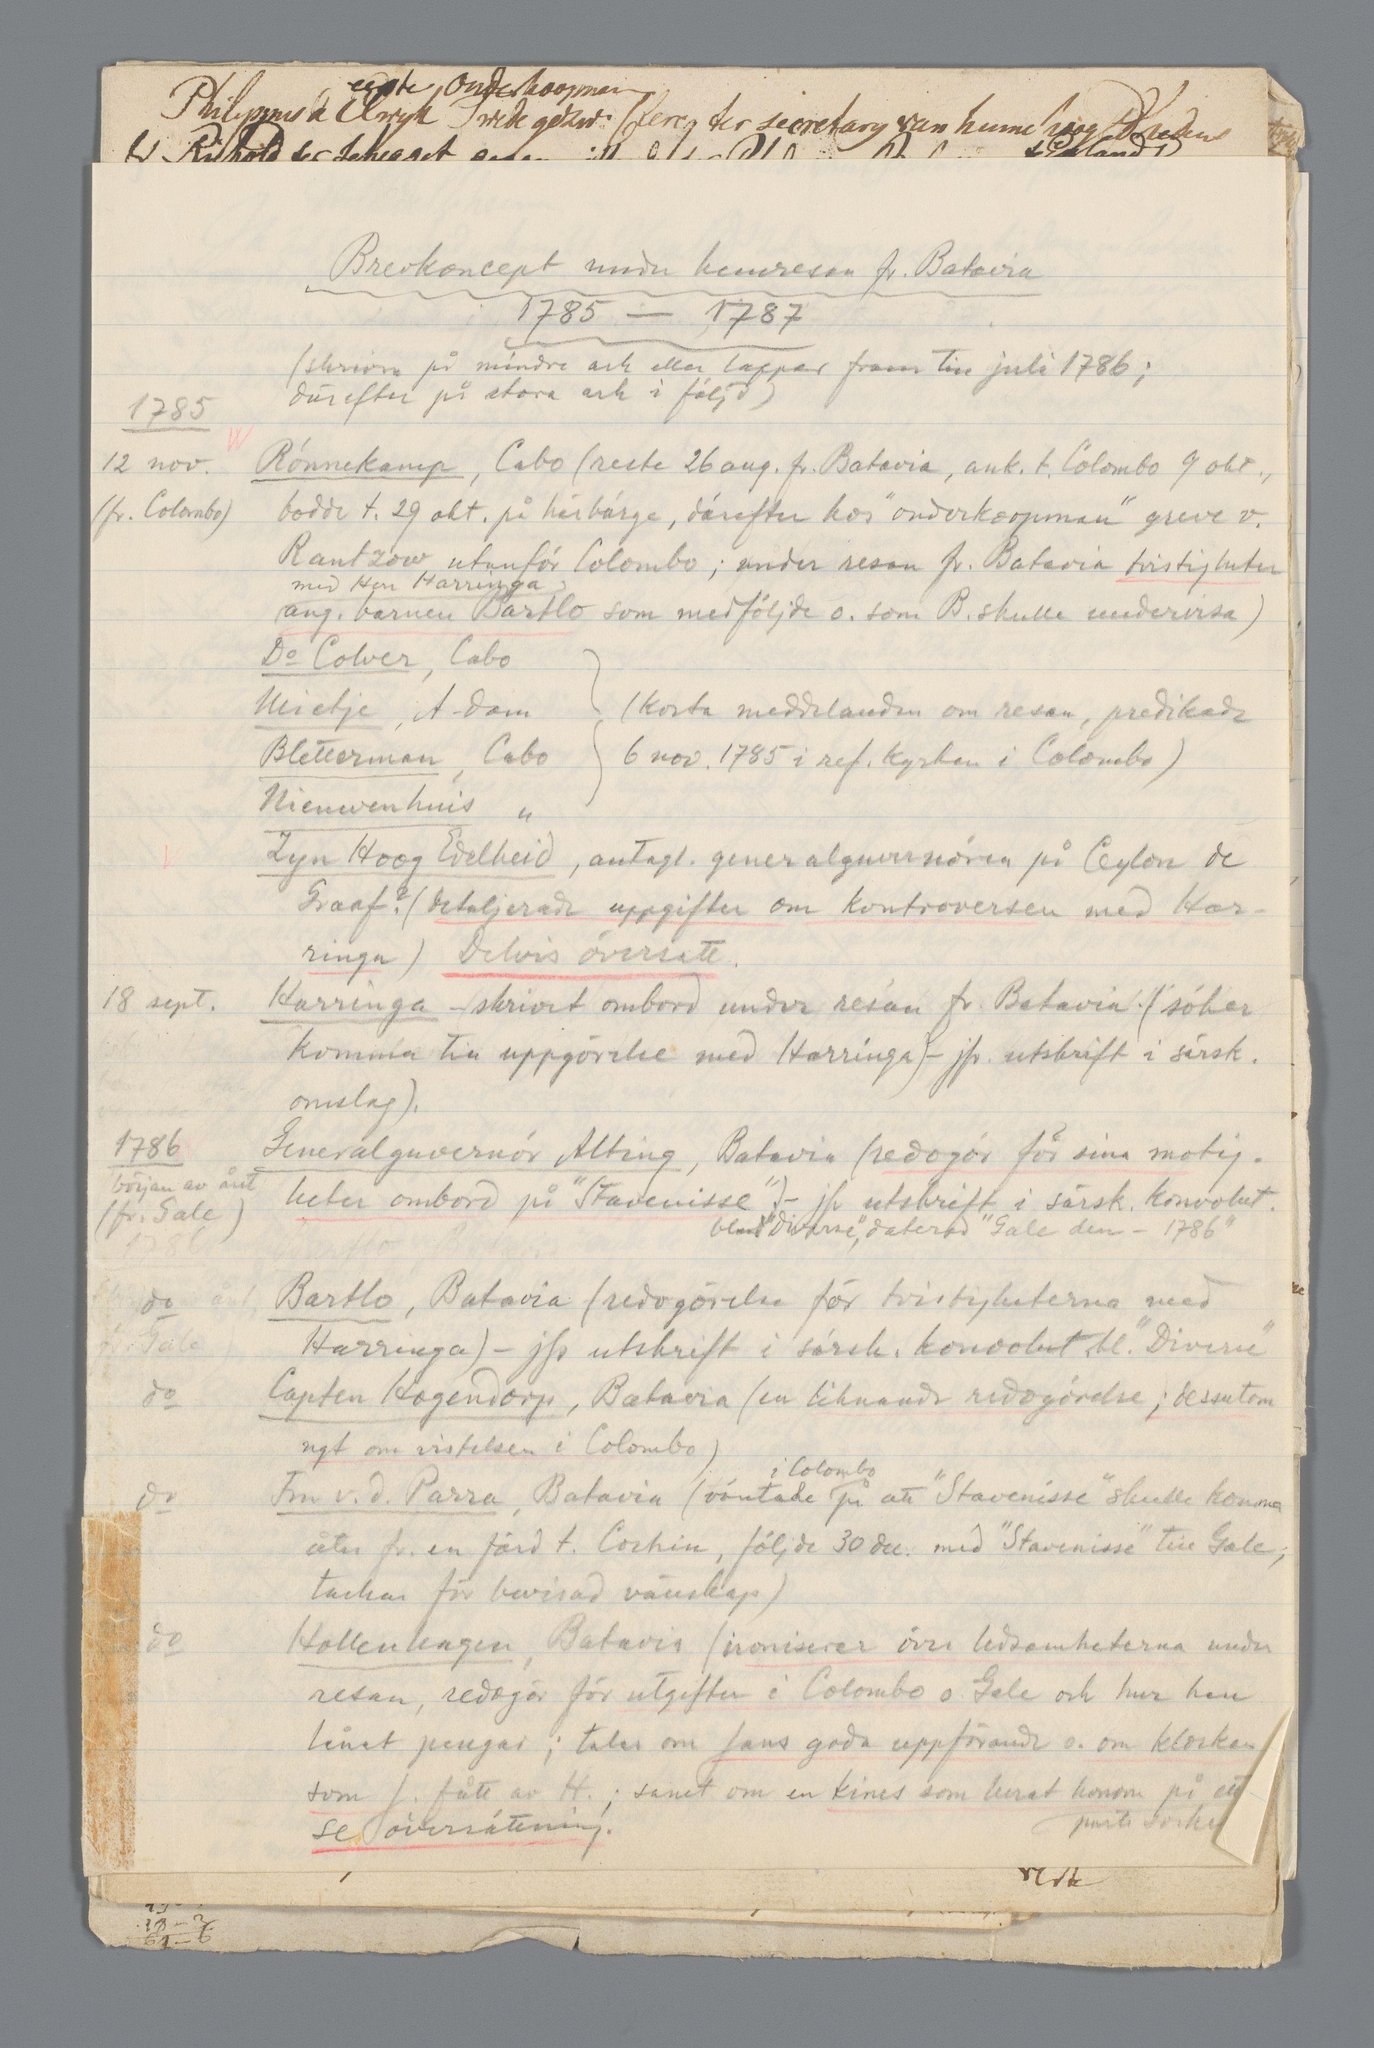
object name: letter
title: Kladbrievenboek Jan Brandes (1743-1808) gedurende zijn reis van Batavia, via Ceylon en de Kaap naar Nederland, 1785-1787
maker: jan brandes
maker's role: draughtsman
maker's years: 1743-1808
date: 1785-1787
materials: paper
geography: cape town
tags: draughtsman, jan brandes, sri lanka, batavia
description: Kladbrievenboek, rechts v.z.v. tabbladen (alfabetisch), A-B ontbreekt.